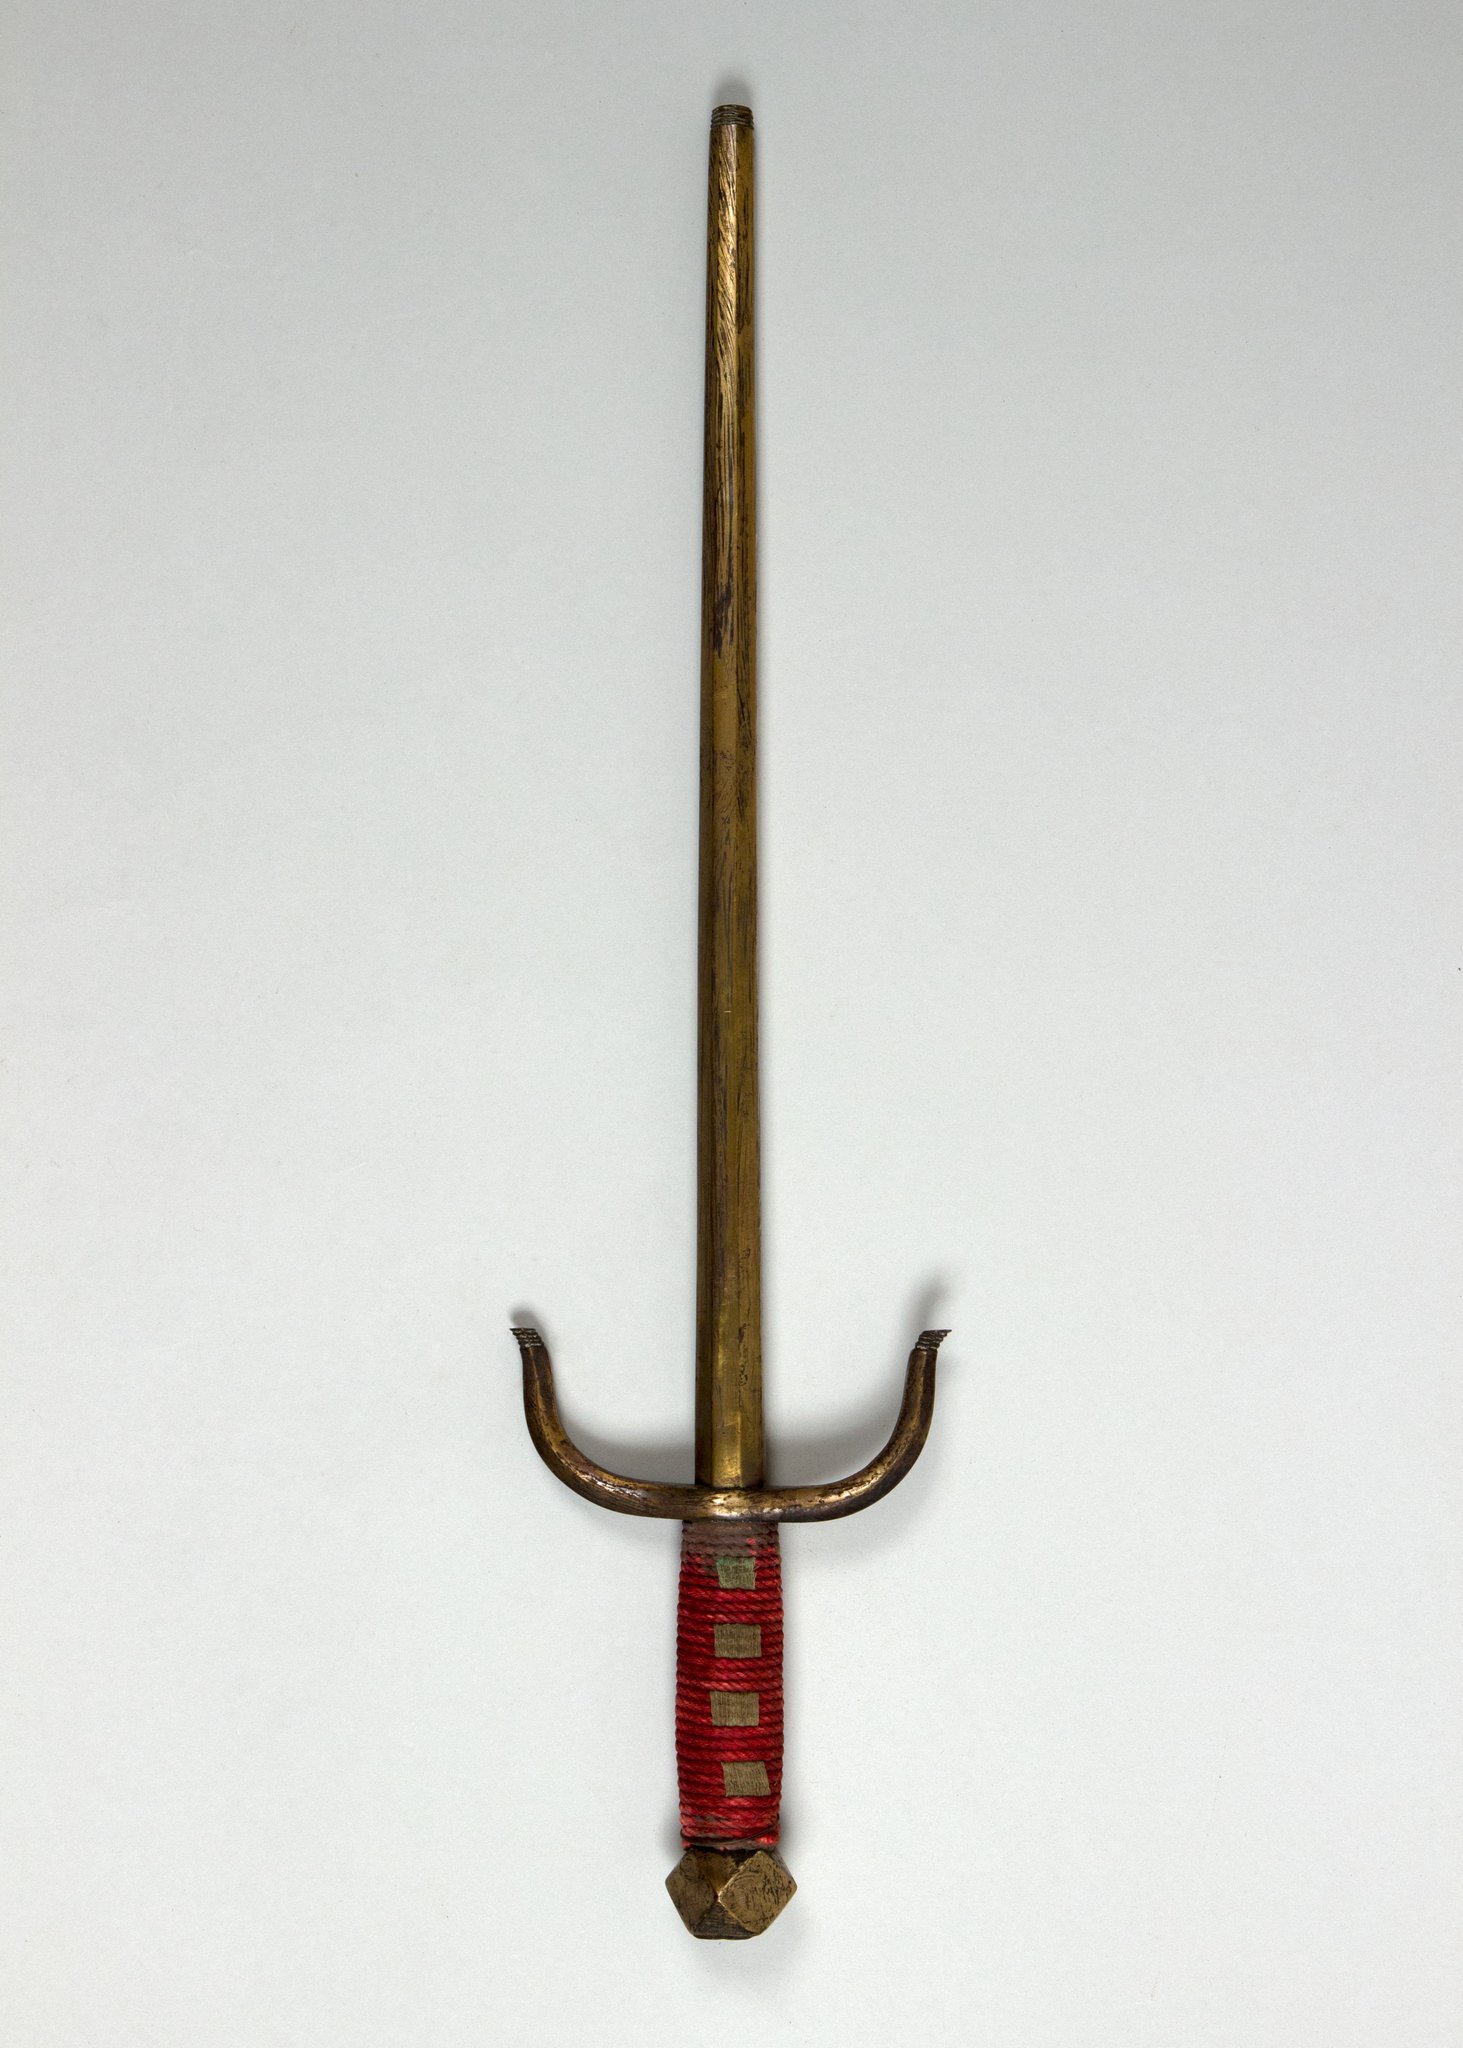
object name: mace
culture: chinese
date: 1701-1900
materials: brass, cord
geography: china